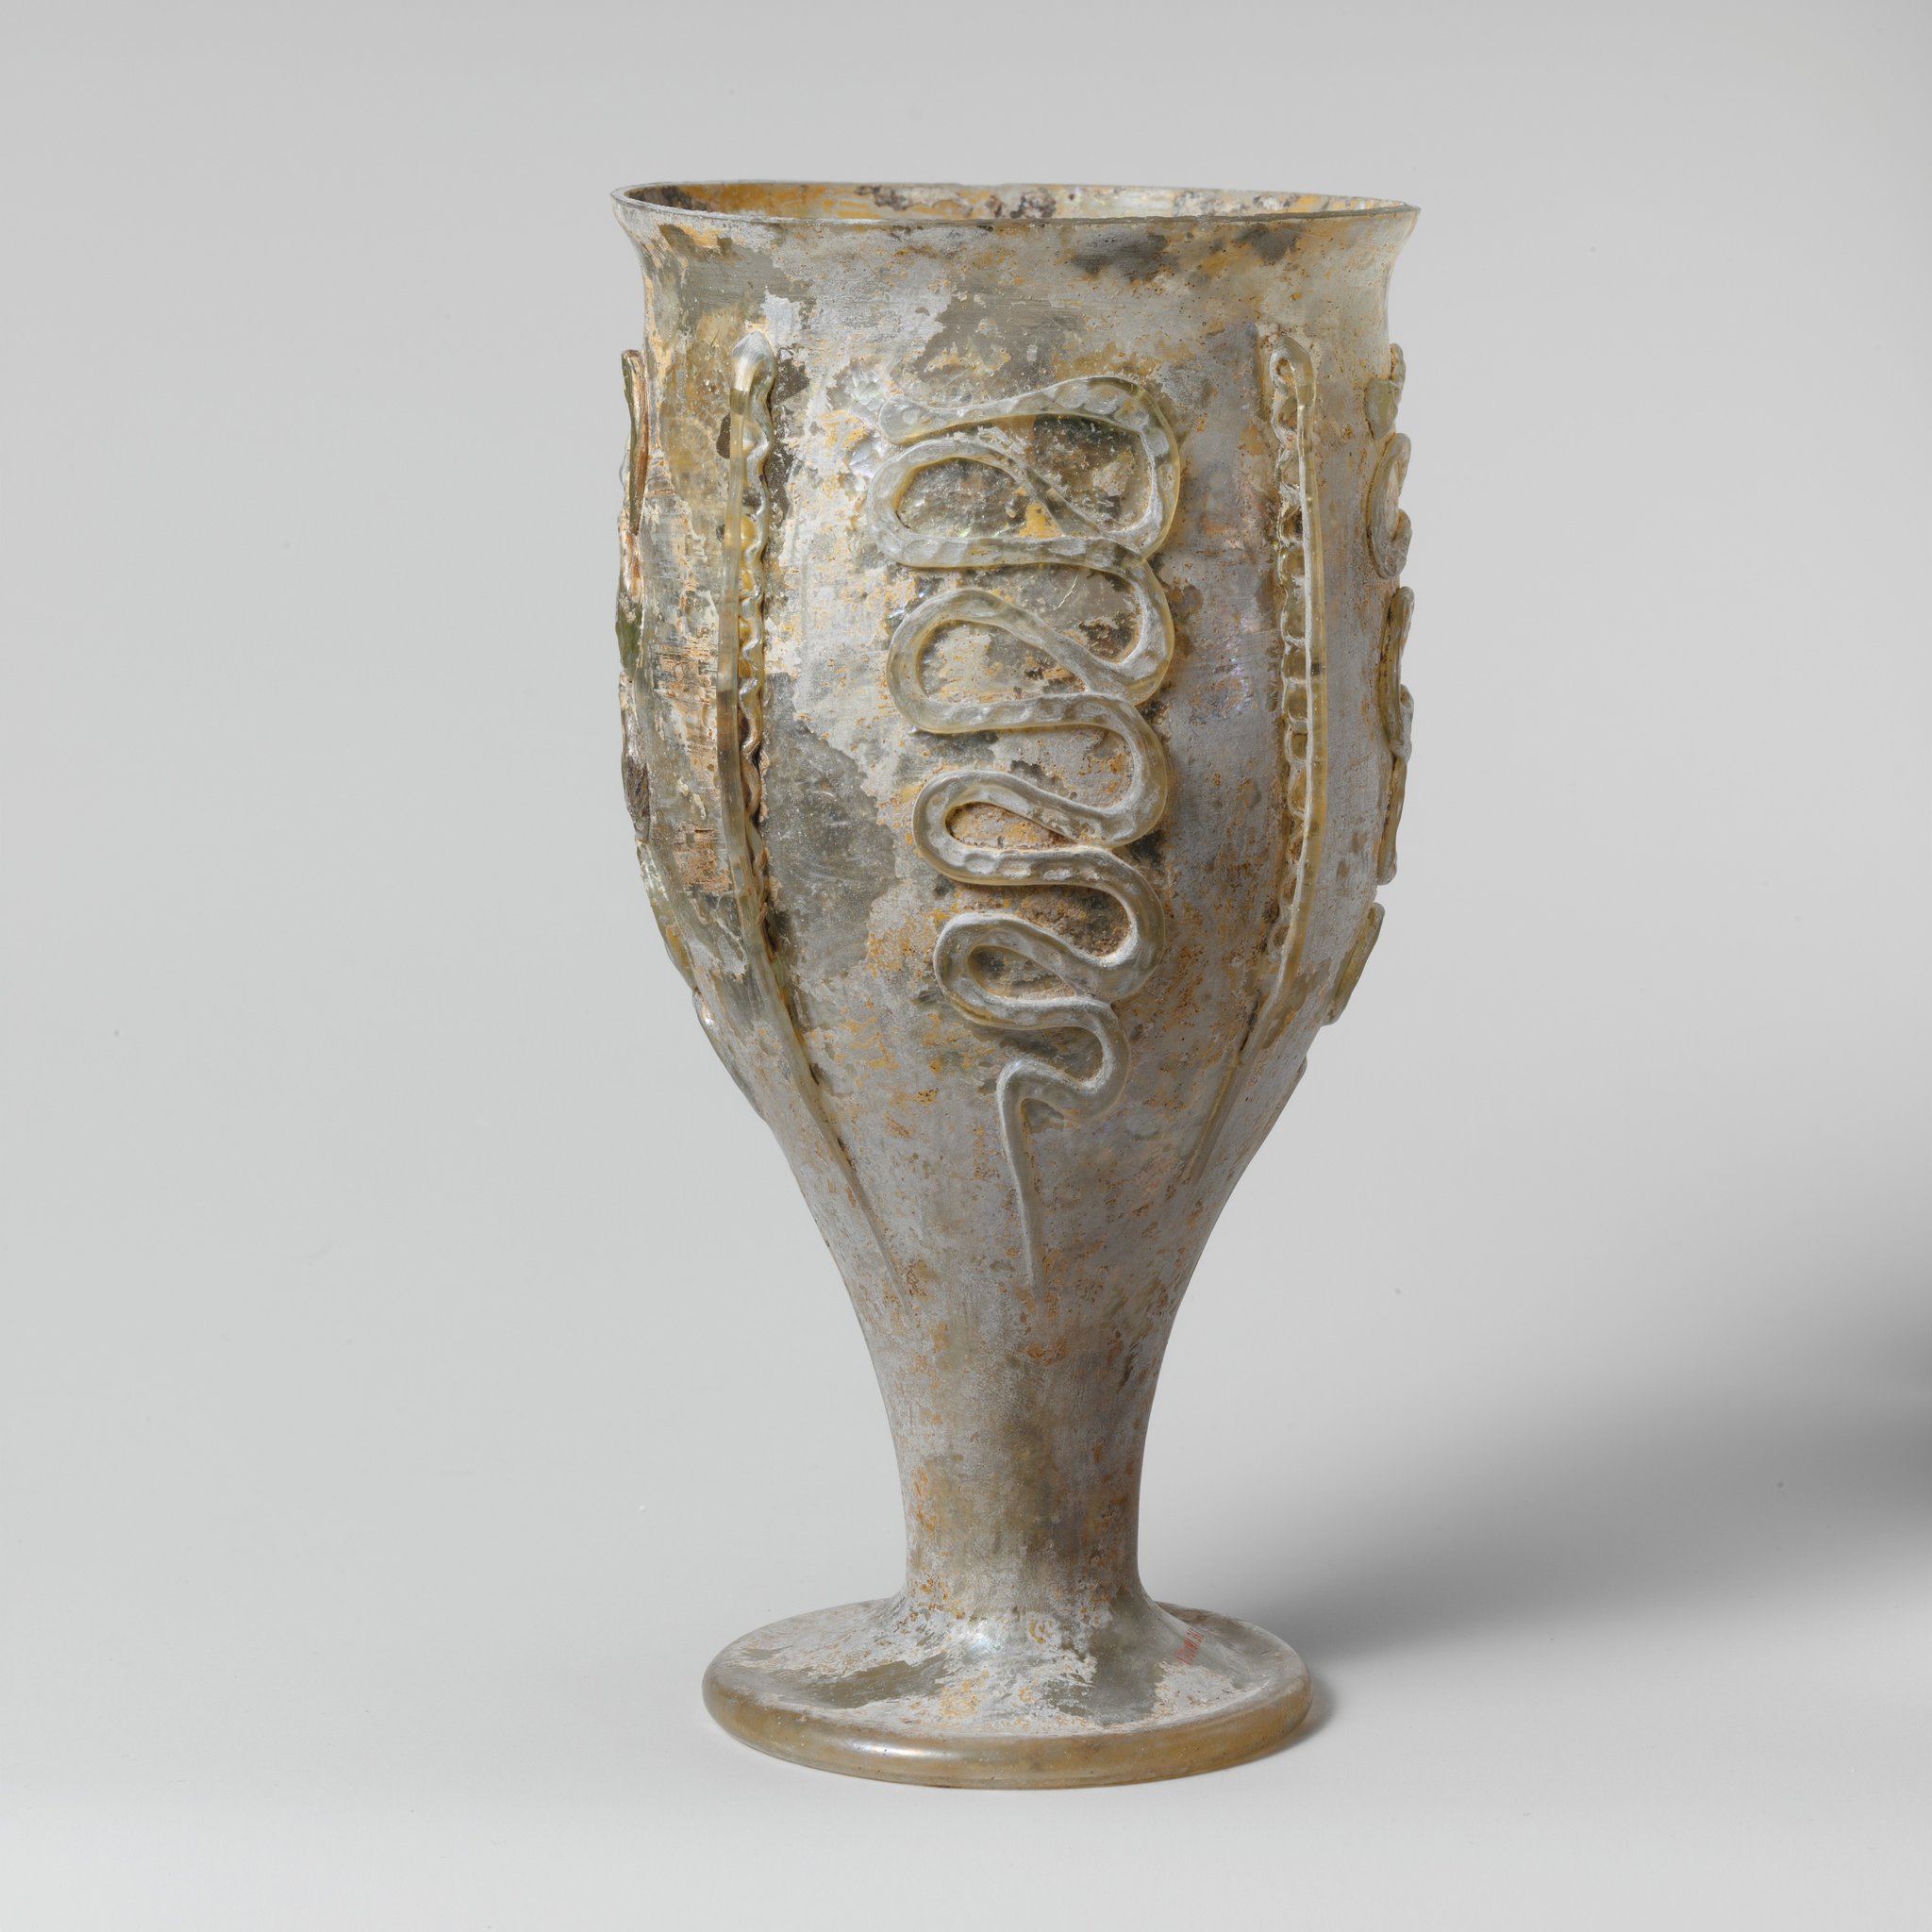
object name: beaker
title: Glass beaker with snake-thread decoration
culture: roman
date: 301-400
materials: glass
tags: snakes